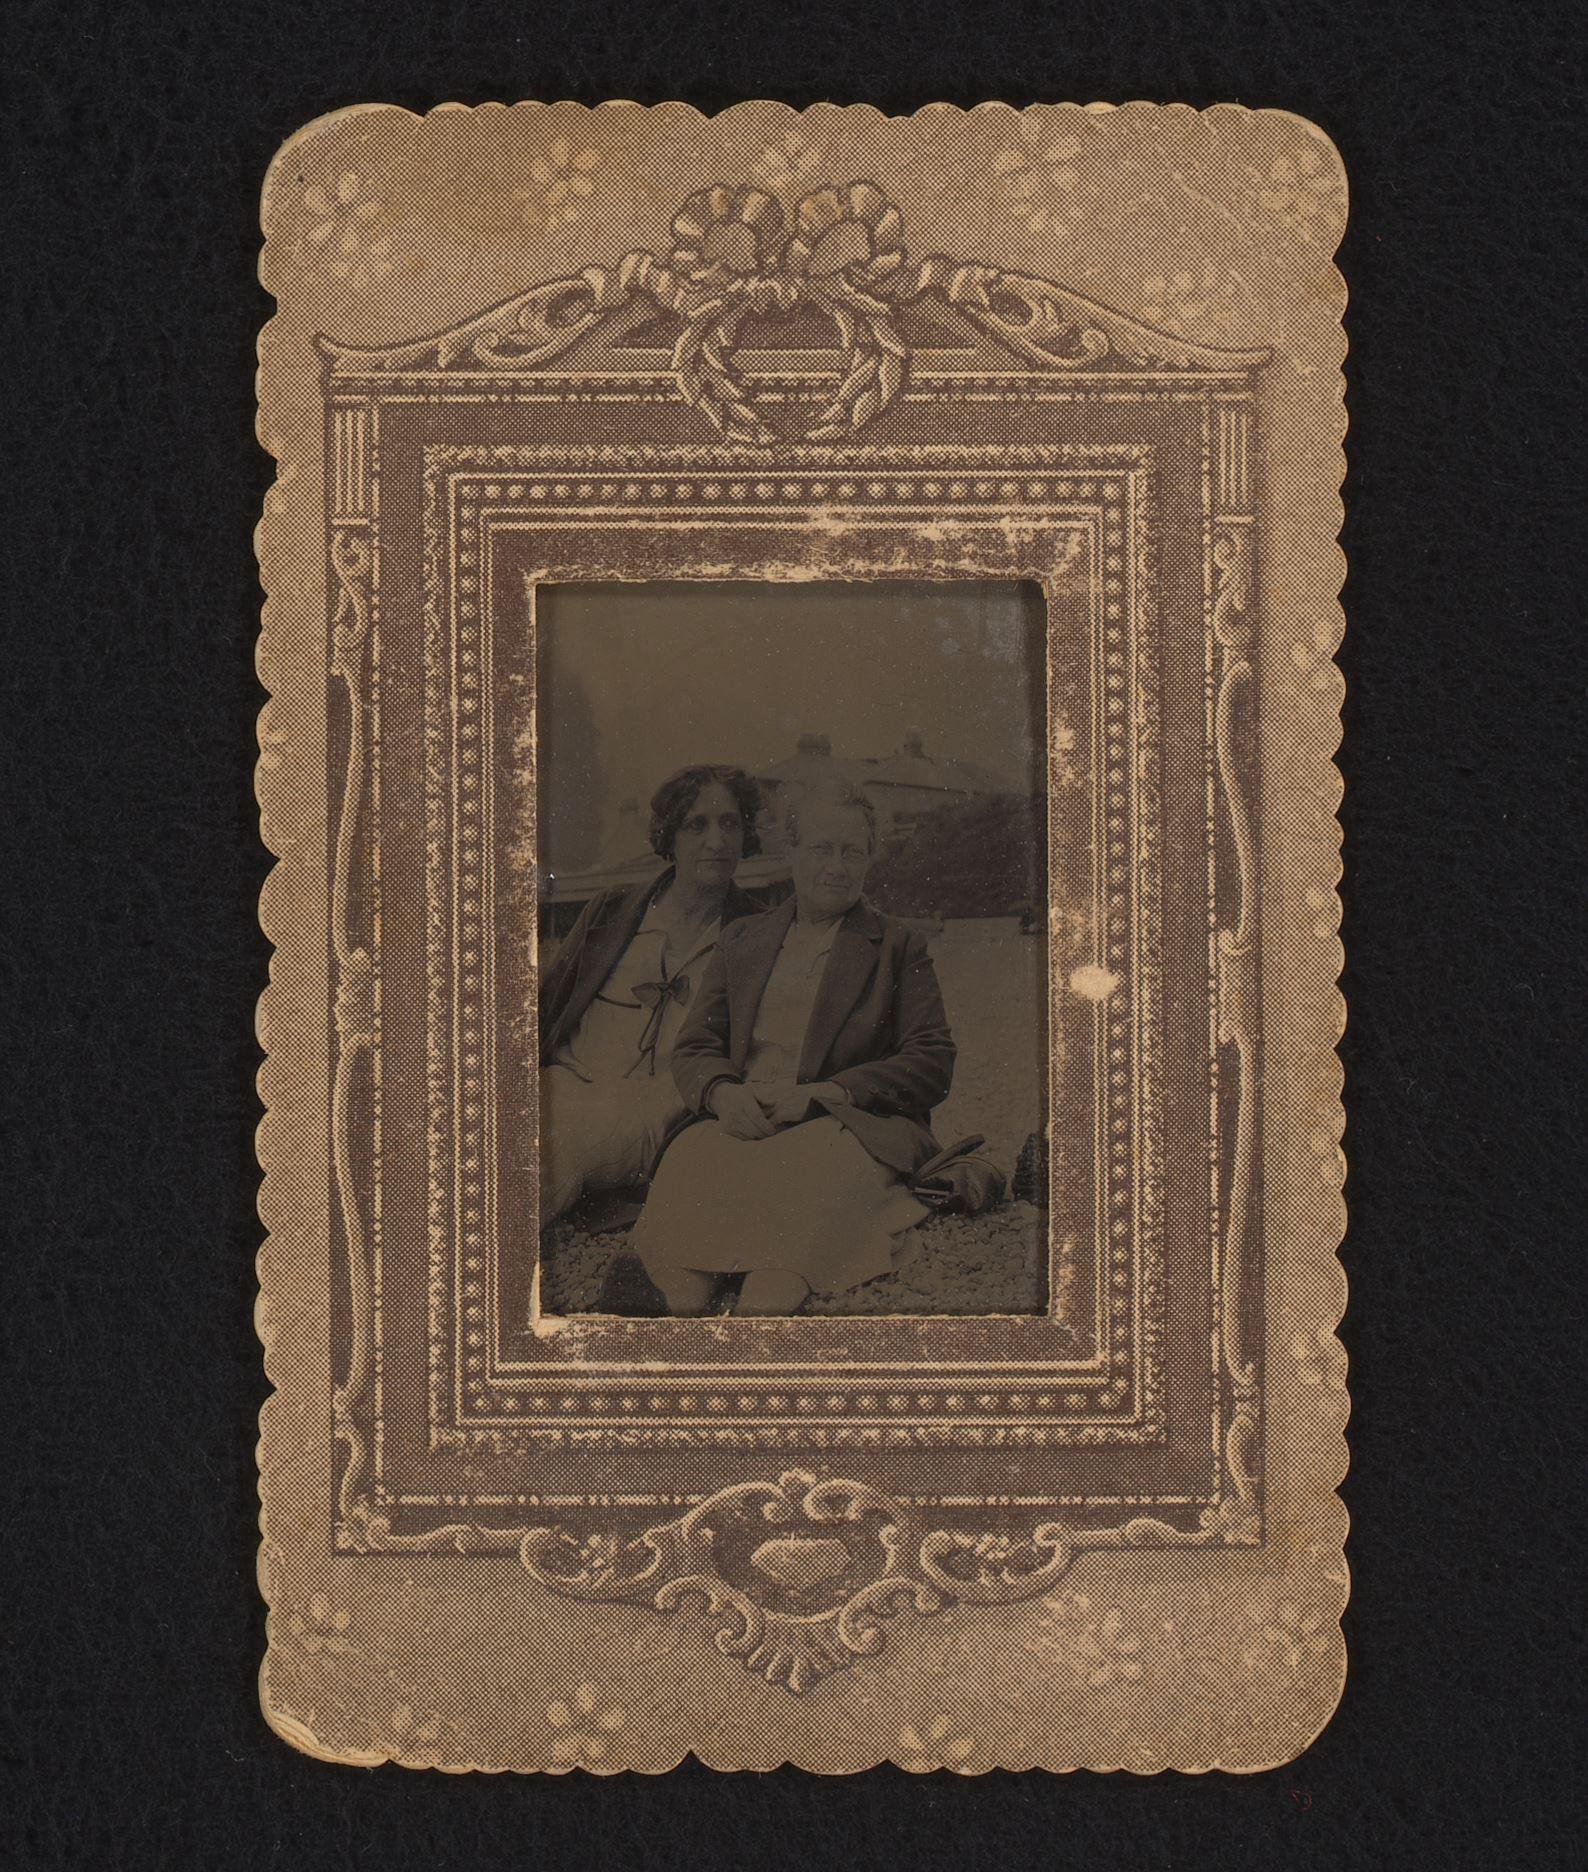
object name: photograph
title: Portret van twee vrouwen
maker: Anonymous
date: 1870-1882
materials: cardboard, iron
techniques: ferrotyping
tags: adult woman, historical persons, beach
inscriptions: annotation: ‘Mother & auntie gone gay/ 1129’